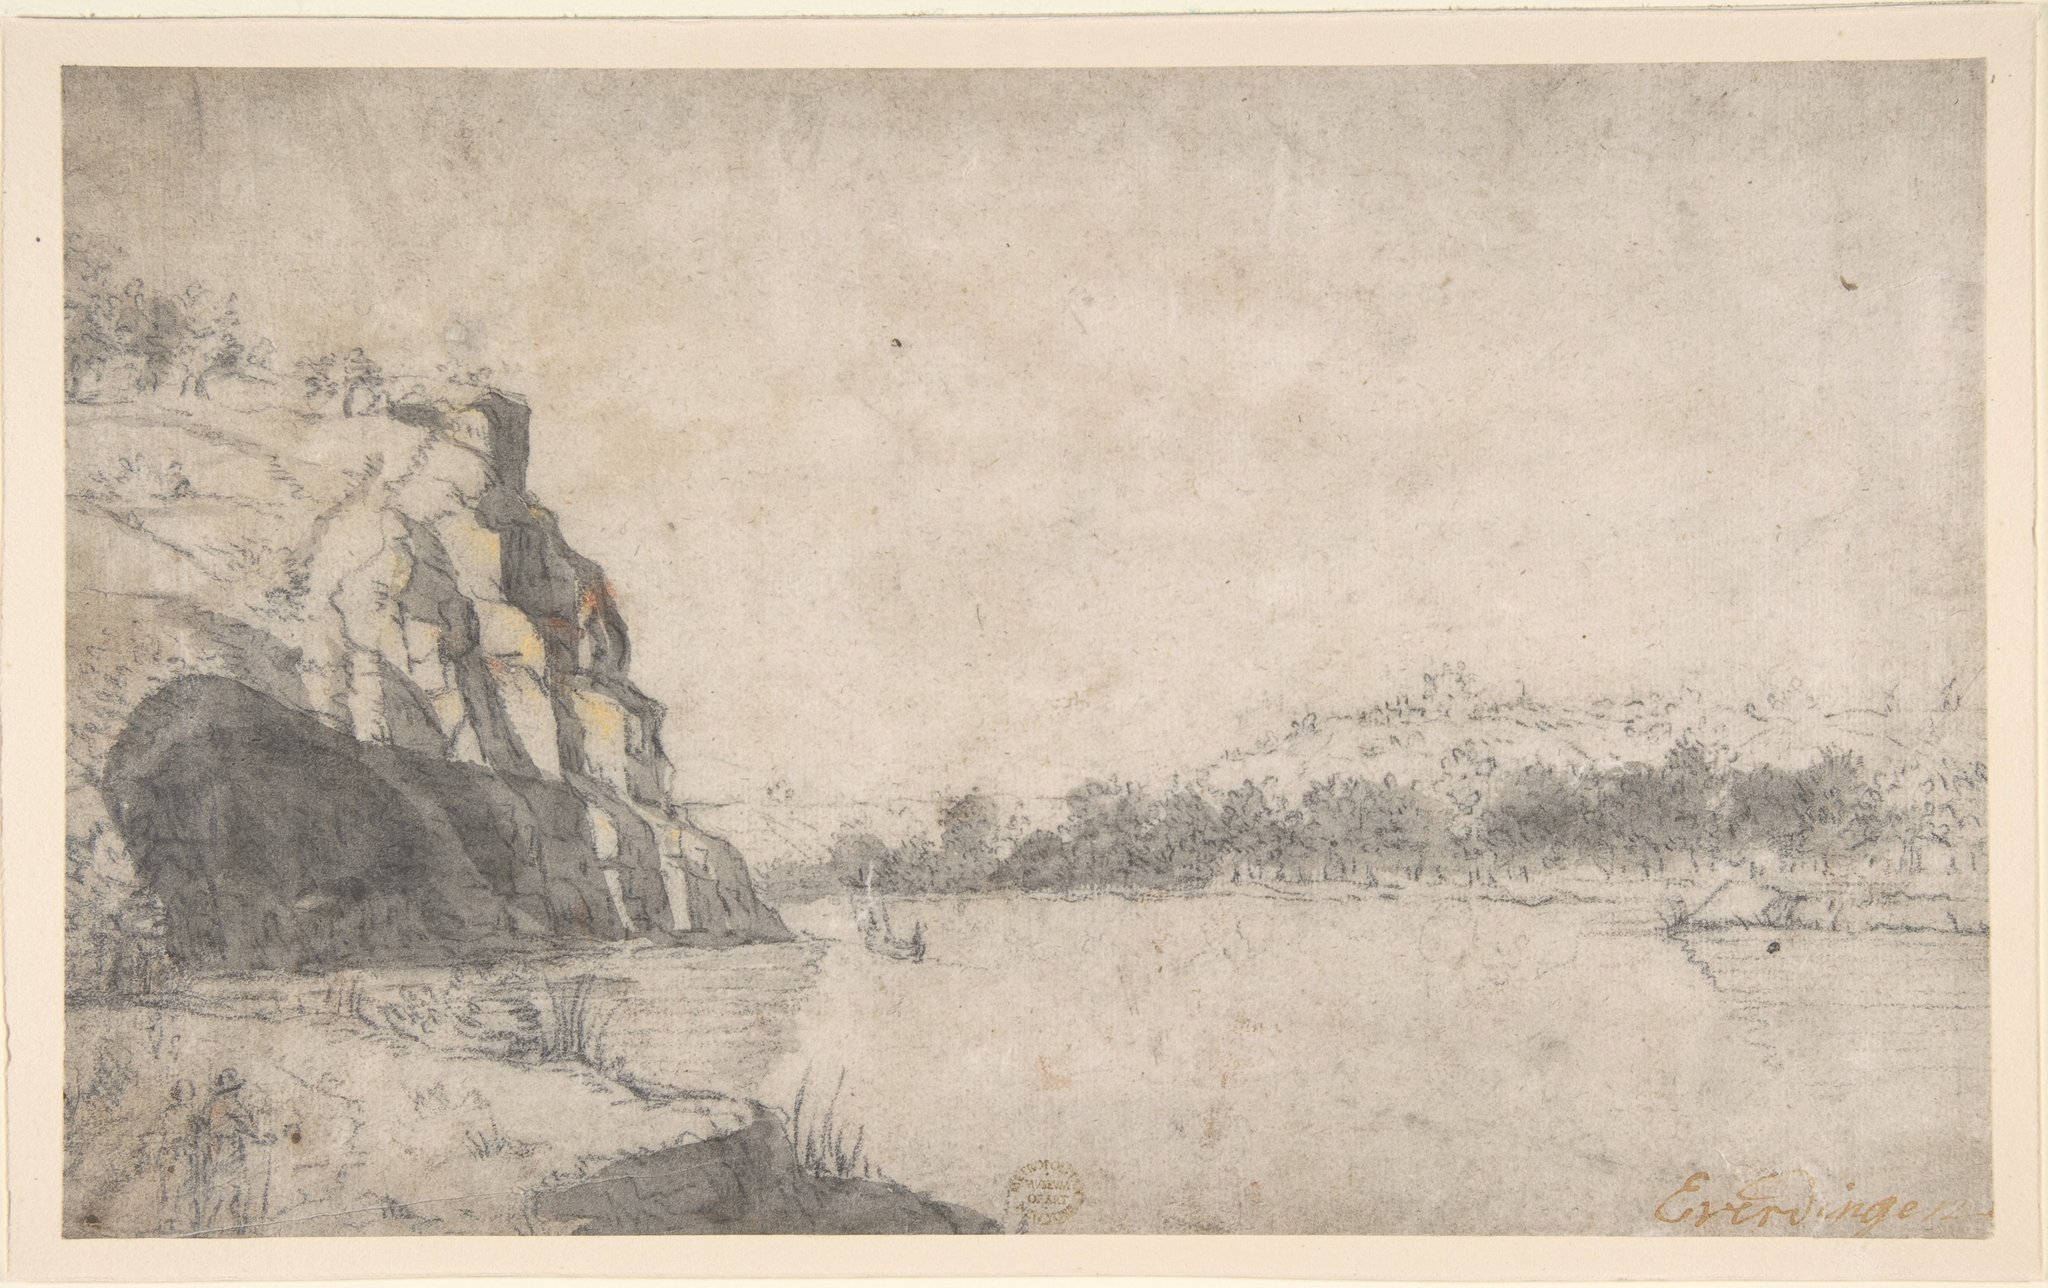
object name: drawing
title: Landscape with River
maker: anonymous, dutch, 17th century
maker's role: artist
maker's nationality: dutch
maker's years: 1600-1700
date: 1601-1700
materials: chalk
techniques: brush, wash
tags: rivers,landscapes,trees